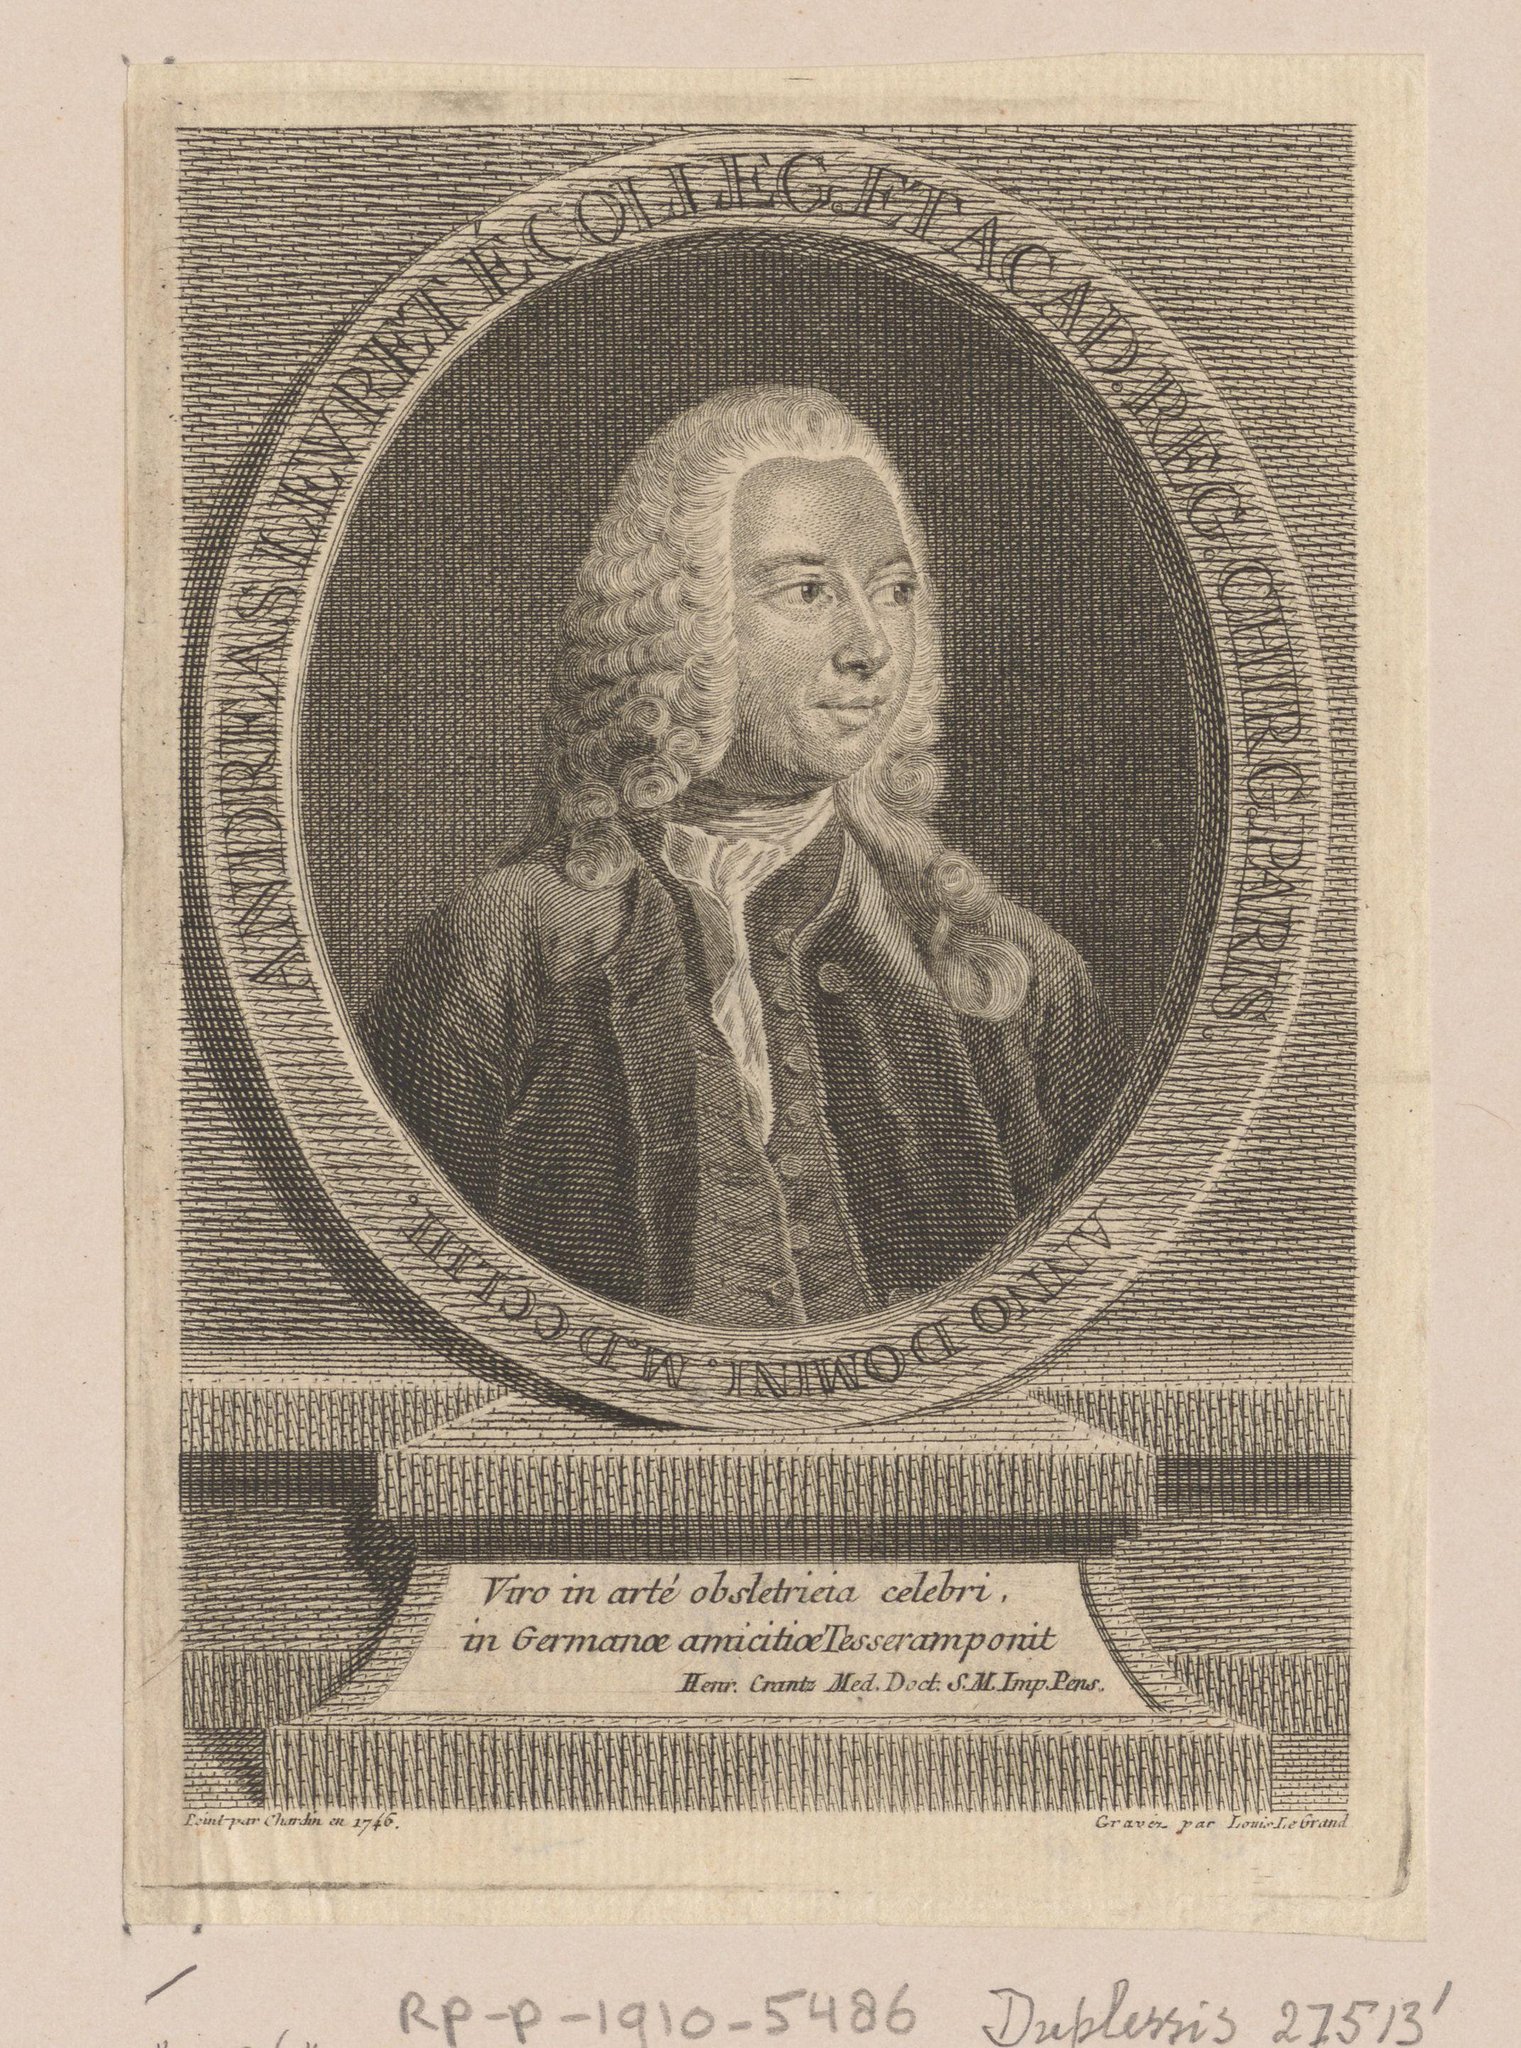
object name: print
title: Portret van André Levret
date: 1760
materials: paper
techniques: engraving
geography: france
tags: ornament ~ medallion, historical persons, physician, doctor (+ portrait of scholar, scientist)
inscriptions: collector's mark: Lugt 2228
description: Met tweeregelig onderschrift in het Latijn.